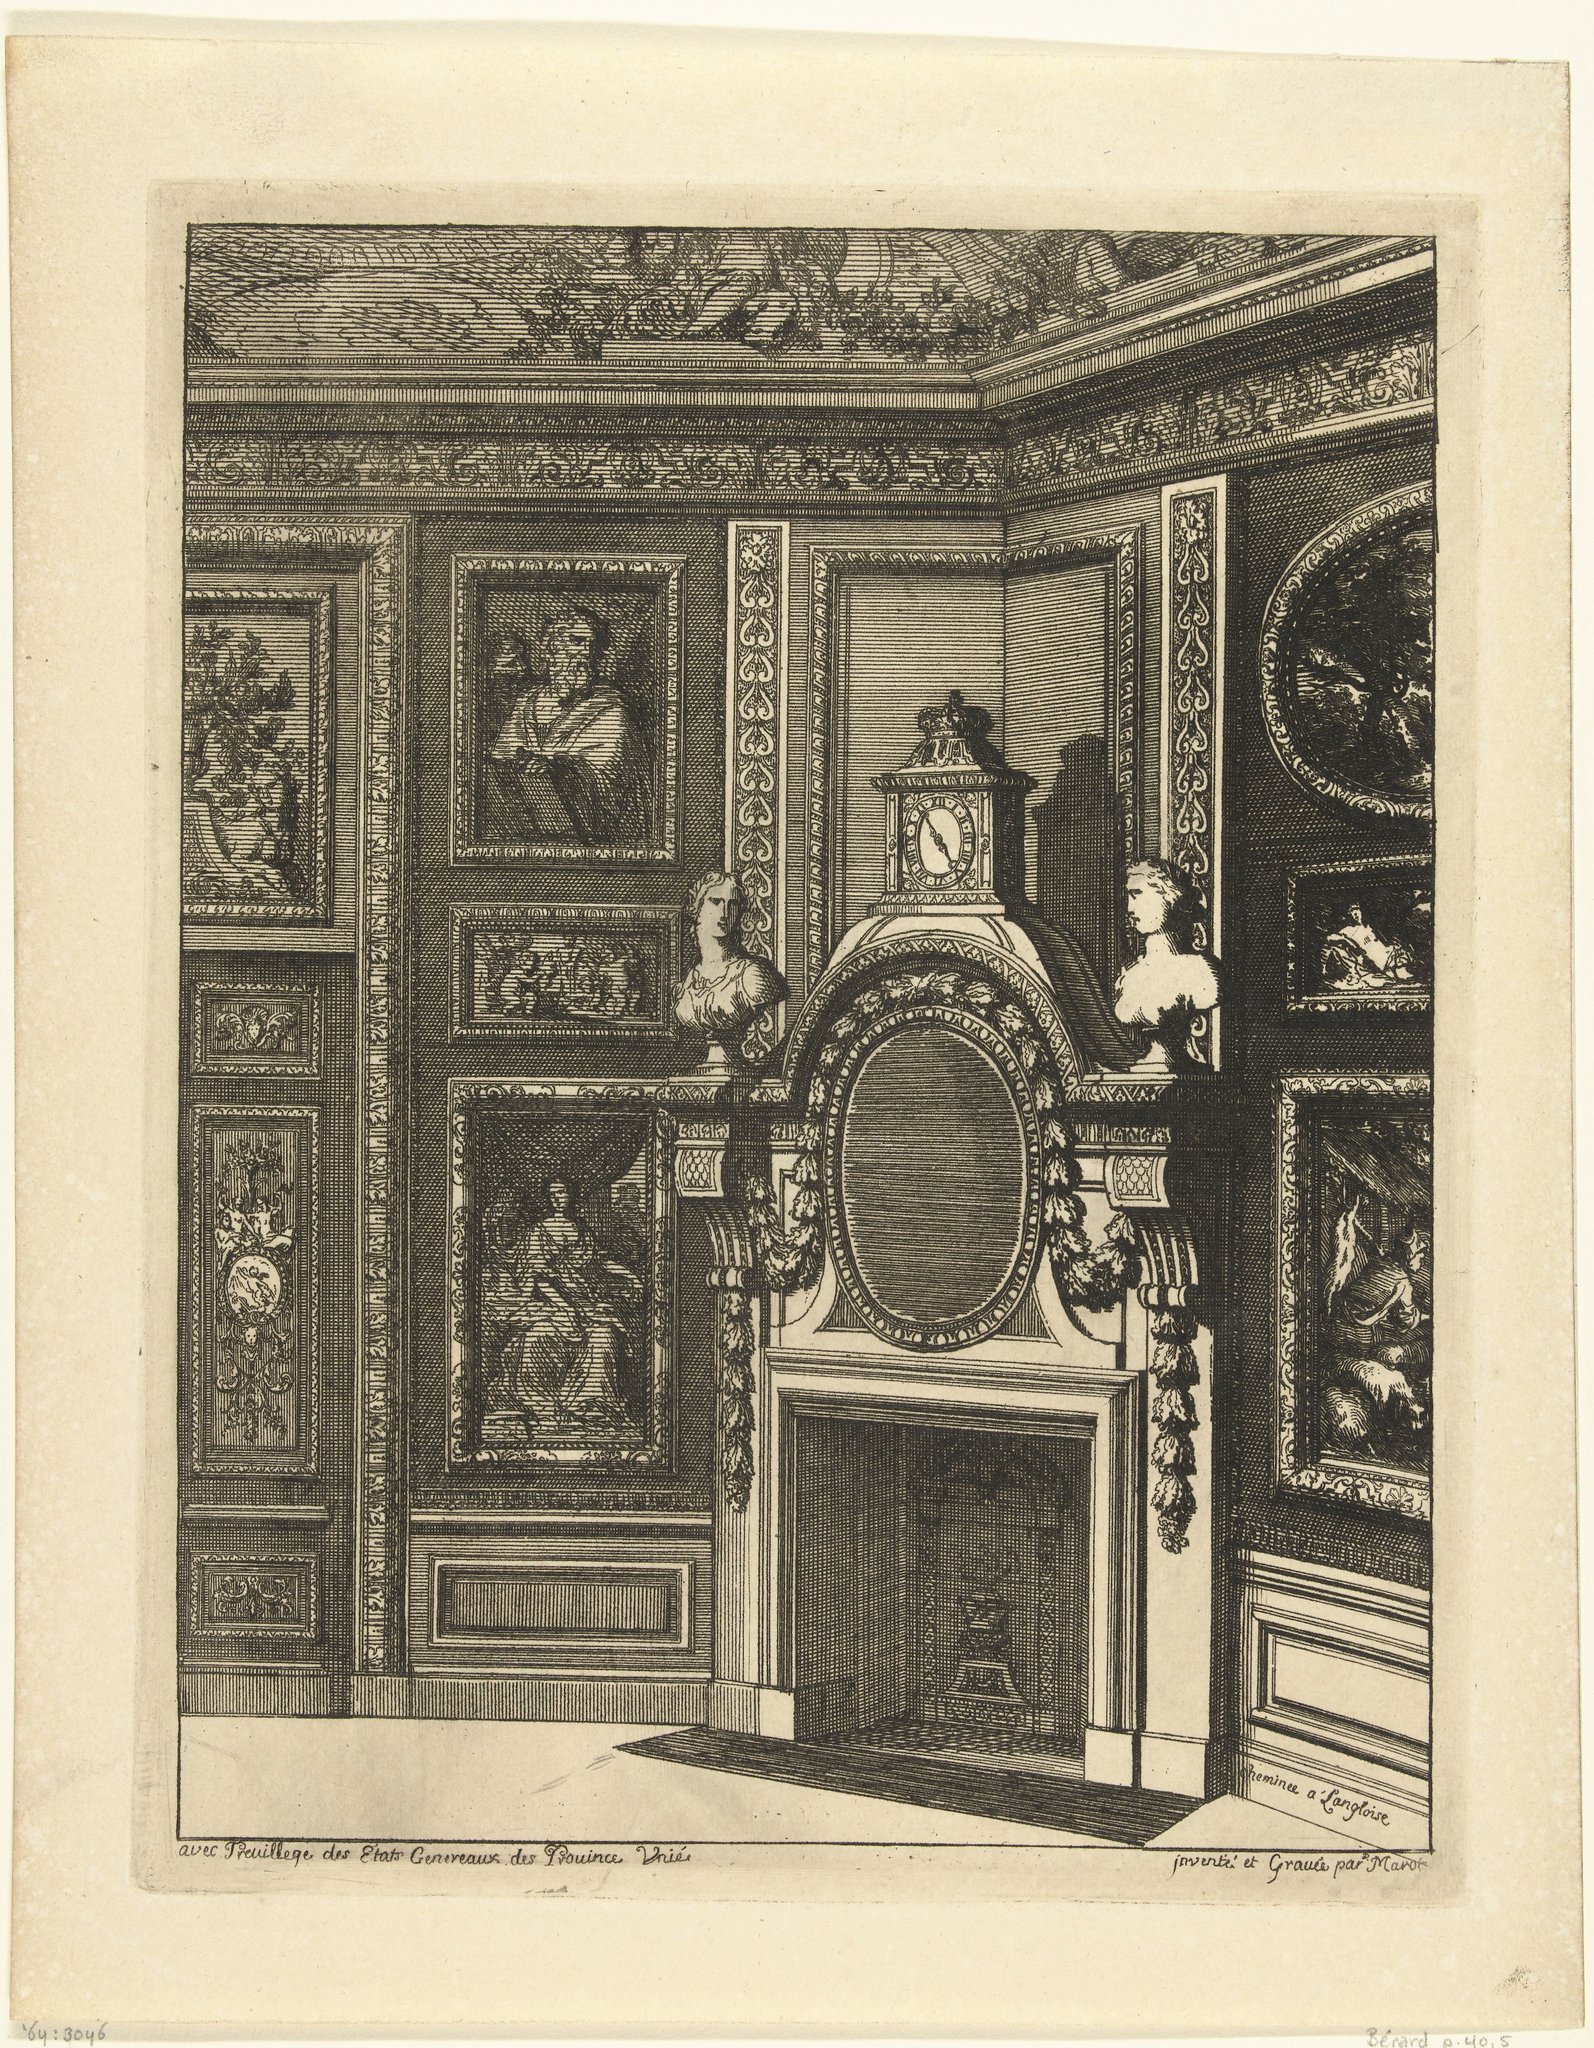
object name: ornament print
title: Engelse onderboezem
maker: daniël marot (i)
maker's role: draughtsman, print maker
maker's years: 1661-1752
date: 1673-1703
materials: paper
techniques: etching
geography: the hague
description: De onderboezem is in een hoek geplaatst. Tussen de schoorsteenboezem en de gebogen kroonlijst hangt een ovale spiegel, boven de kroonlijst is een koepel met een bekroonde klok. Uit serie van 6 bladen.